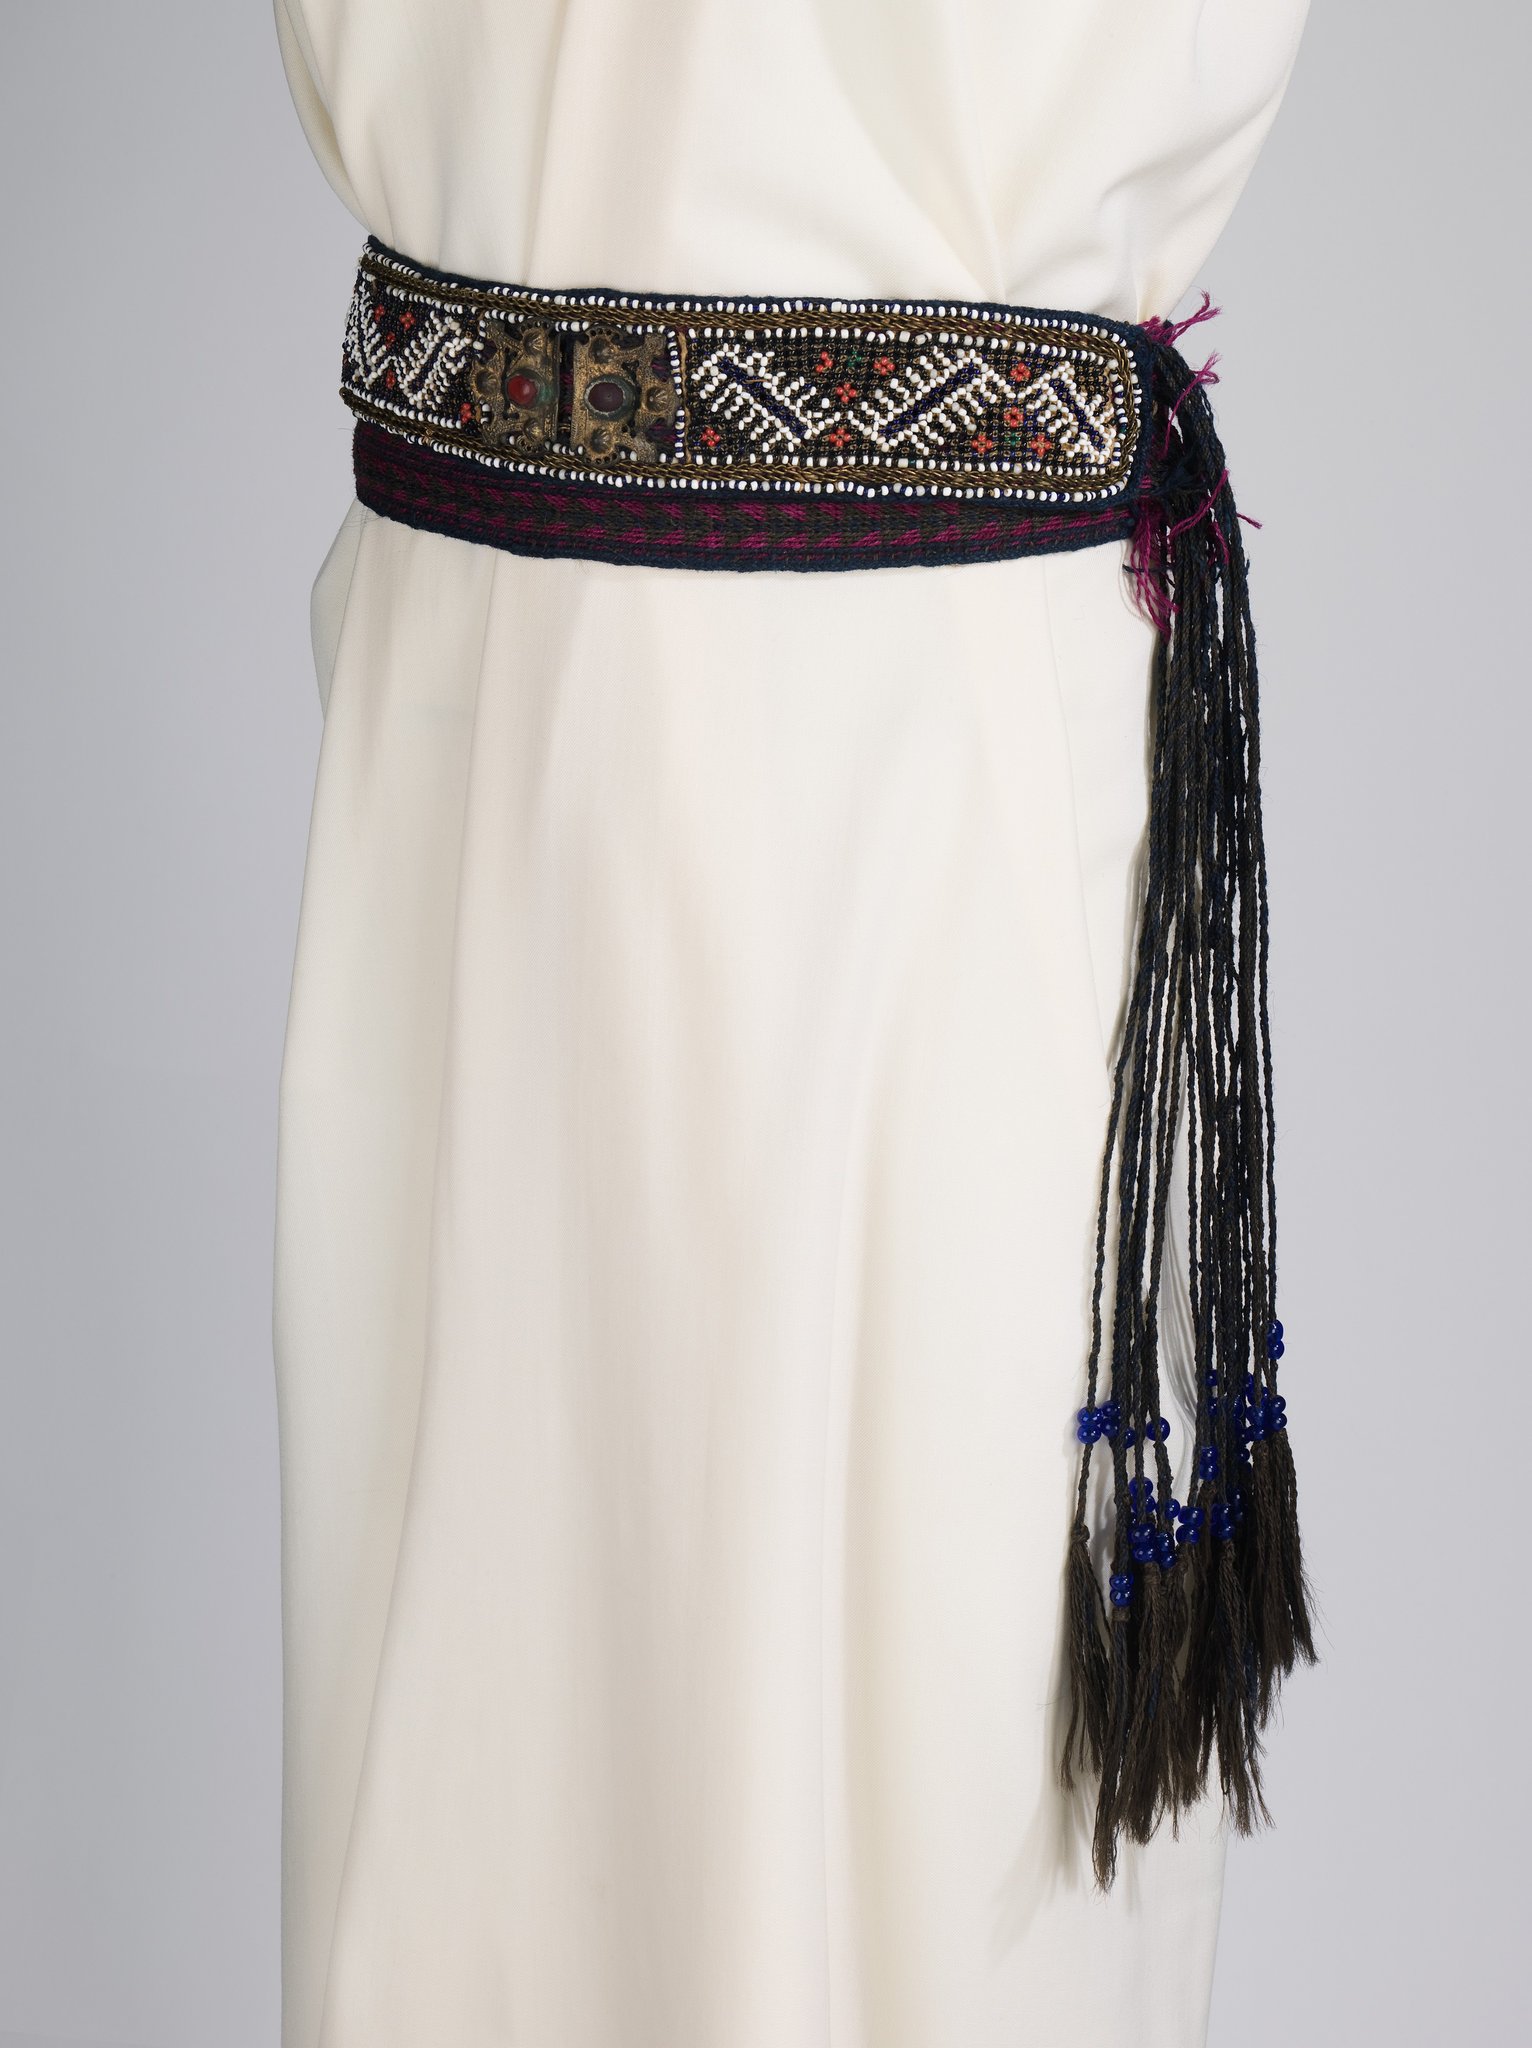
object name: belt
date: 1801-1900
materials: glass, metal, wool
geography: yugoslavia